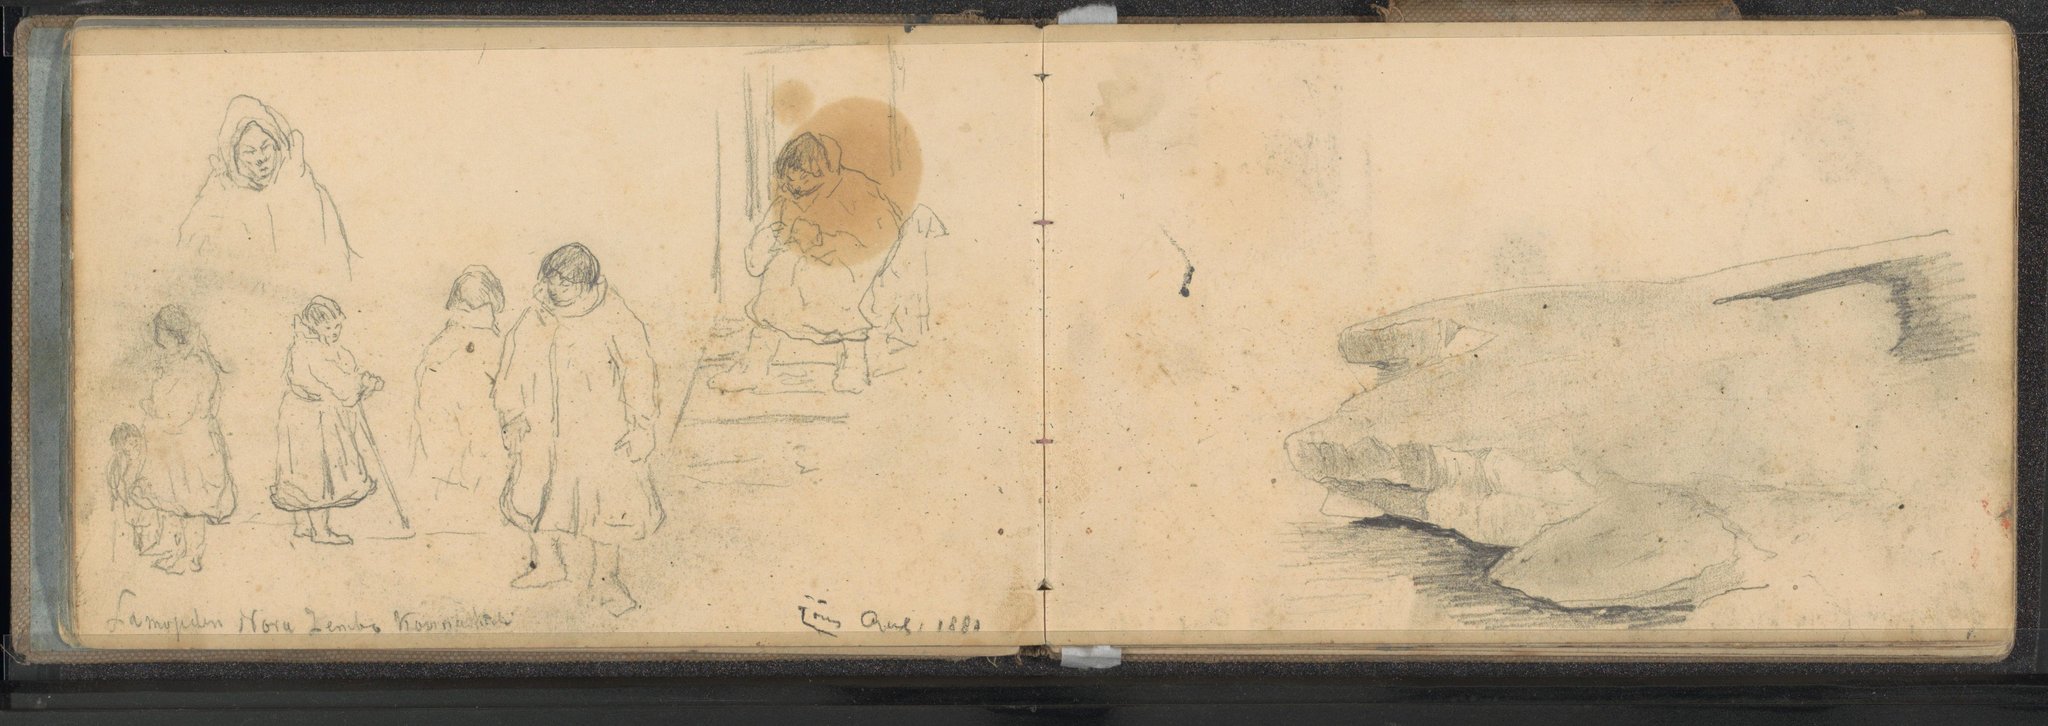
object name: sketchbook leaf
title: Samojeden te Malye Karmakuly, Nova Zembla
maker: louis apol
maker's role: draughtsman, painter, print maker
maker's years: 1850-1936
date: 1880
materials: paper, pencil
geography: malye karmakuly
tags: adult woman, adult man, child, dog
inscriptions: annotation: ‘Samojeden Nova Zembla Karmakuli’, signature: ‘Louis Apol, 1880’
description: Blad 16 verso uit een schetsboek met 35 bladen betekend tijdens de expeditie naar Nova Zembla in 1880.